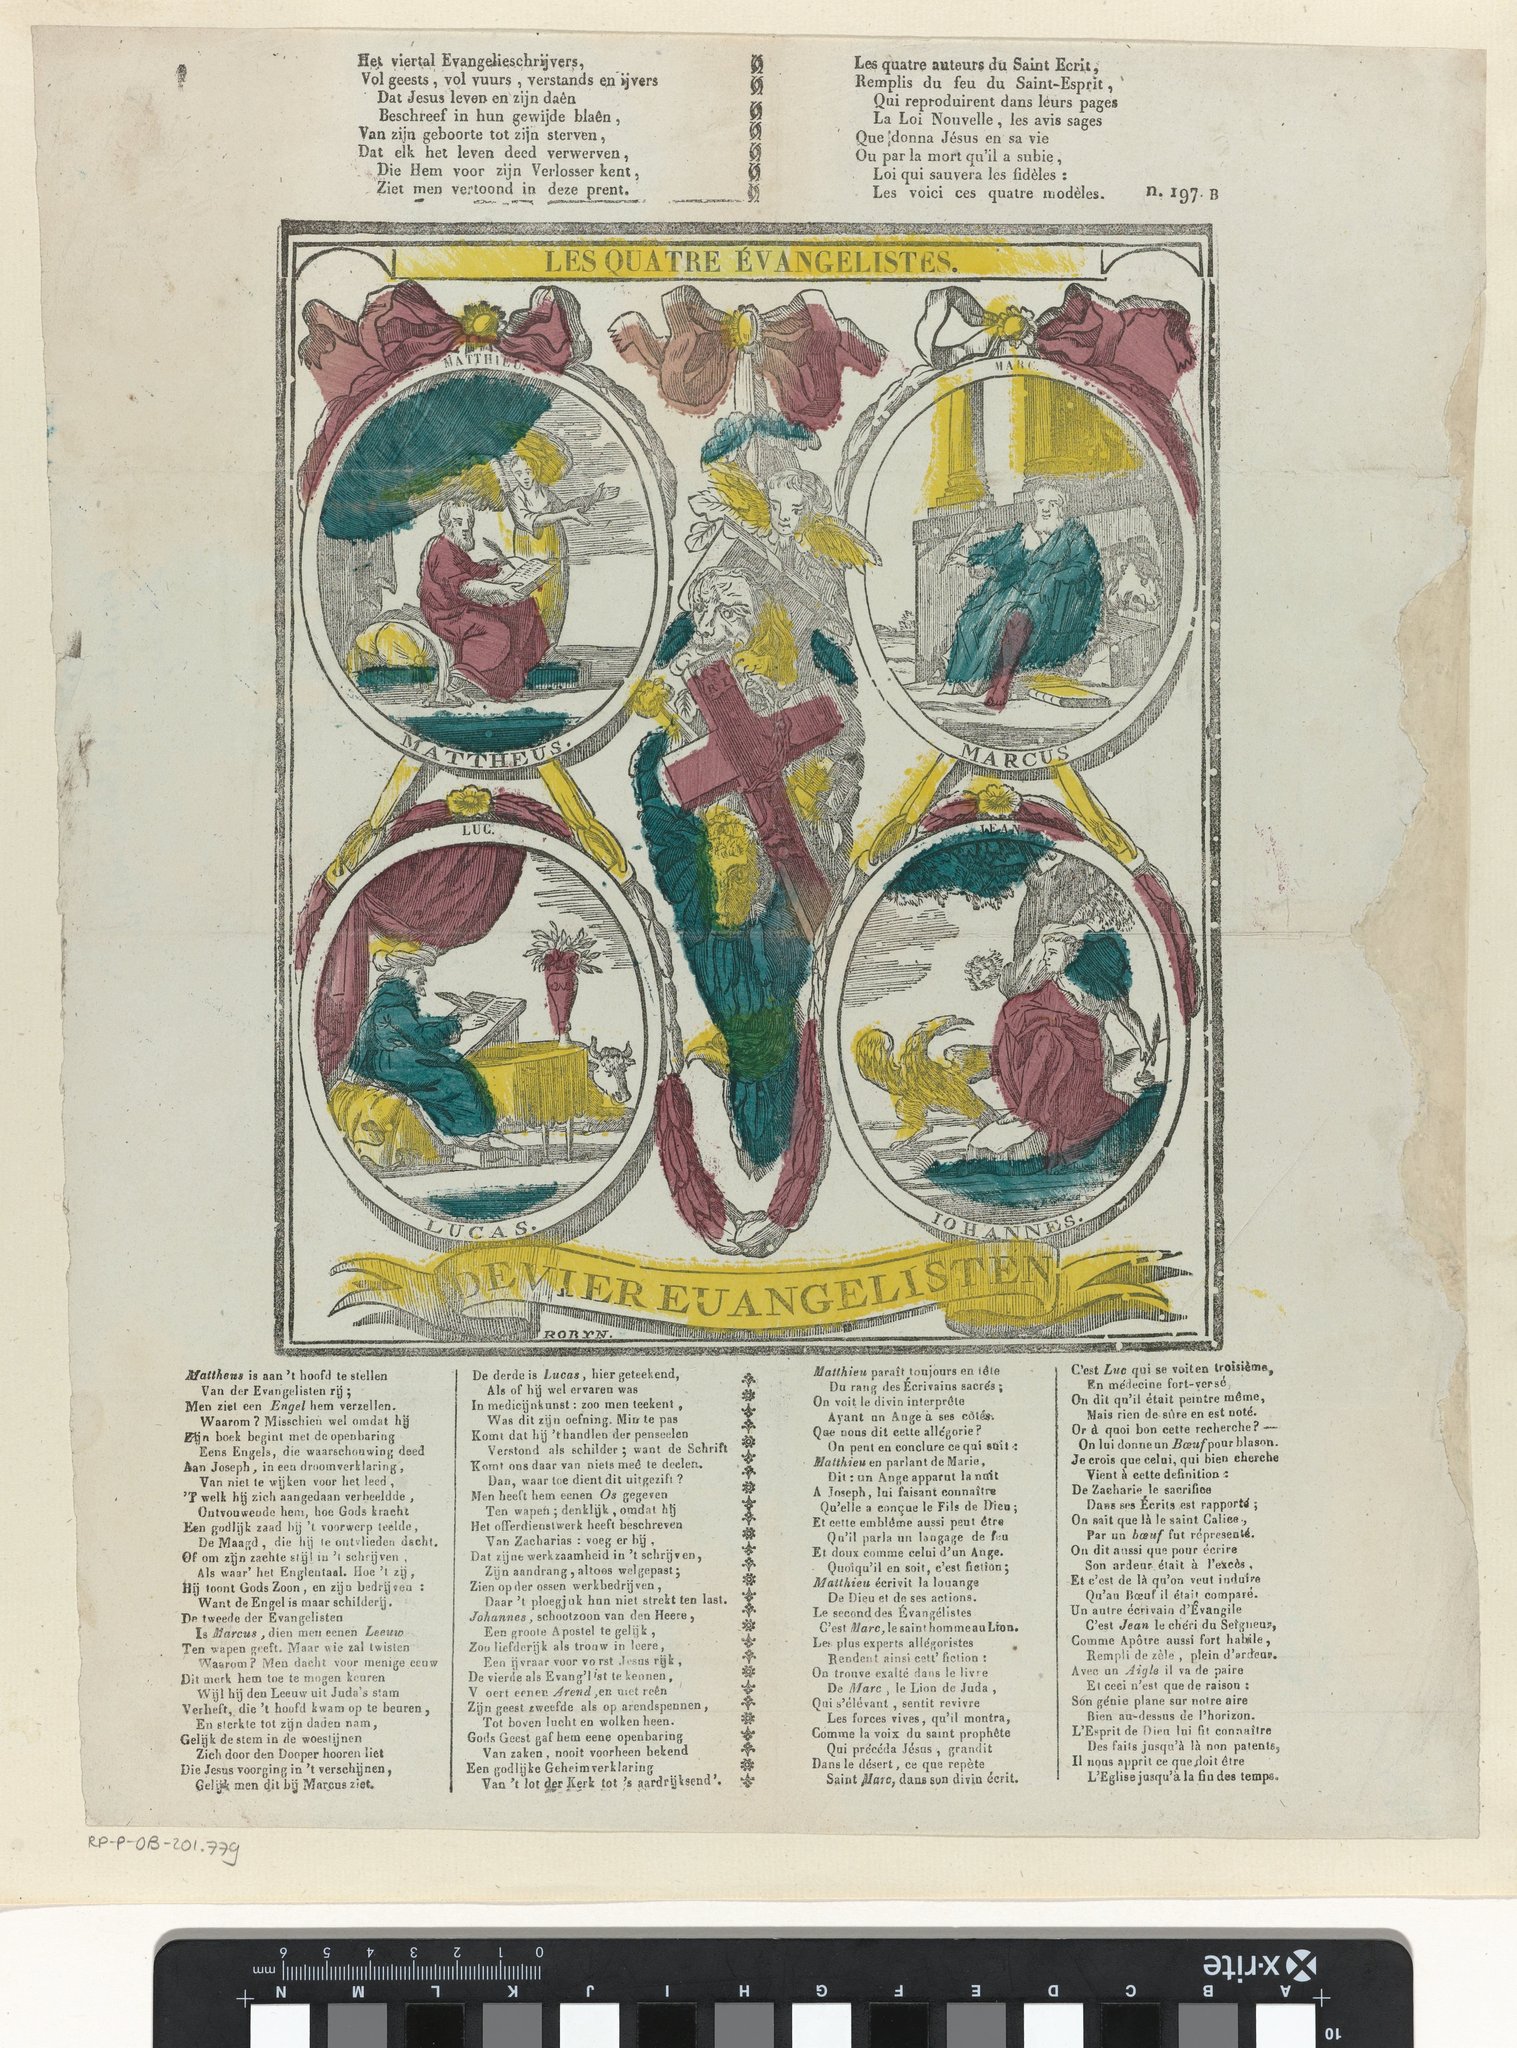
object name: print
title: Le quatres évangelistes / De vier evangelisten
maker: philippus jacobus brepols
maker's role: printer, publisher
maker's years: 1778-1845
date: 1800-1833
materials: paper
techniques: colour, letterpress printing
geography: turnhout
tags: the four symbols of the evangelists, 'the apocalyptic beasts'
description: Vier medailles met voorstellingen van de vier evangelisten met hun attributen. Tussen de medailles een festoen met de symbolen van de evangelisten. Boven- en onderschrift in het Nederlands en in het Frans. Genummerd rechtsboven: n. 197. B.